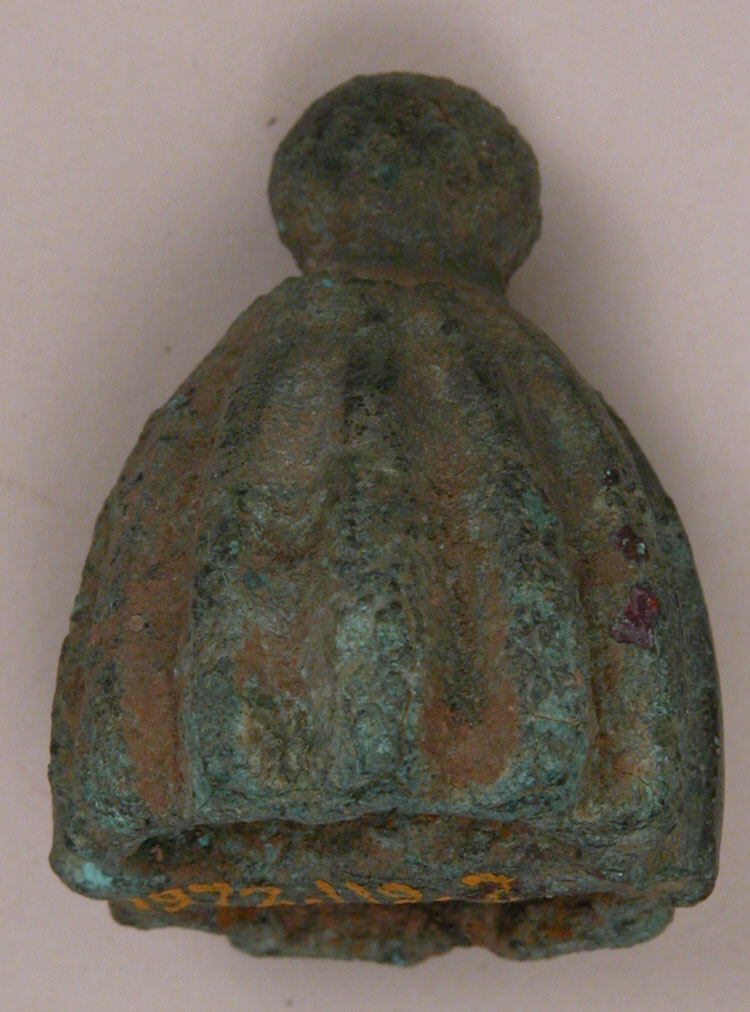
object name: chess piece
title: Chess Piece, probably a Pawn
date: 701-1100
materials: bronze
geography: western islamic lands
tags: chess